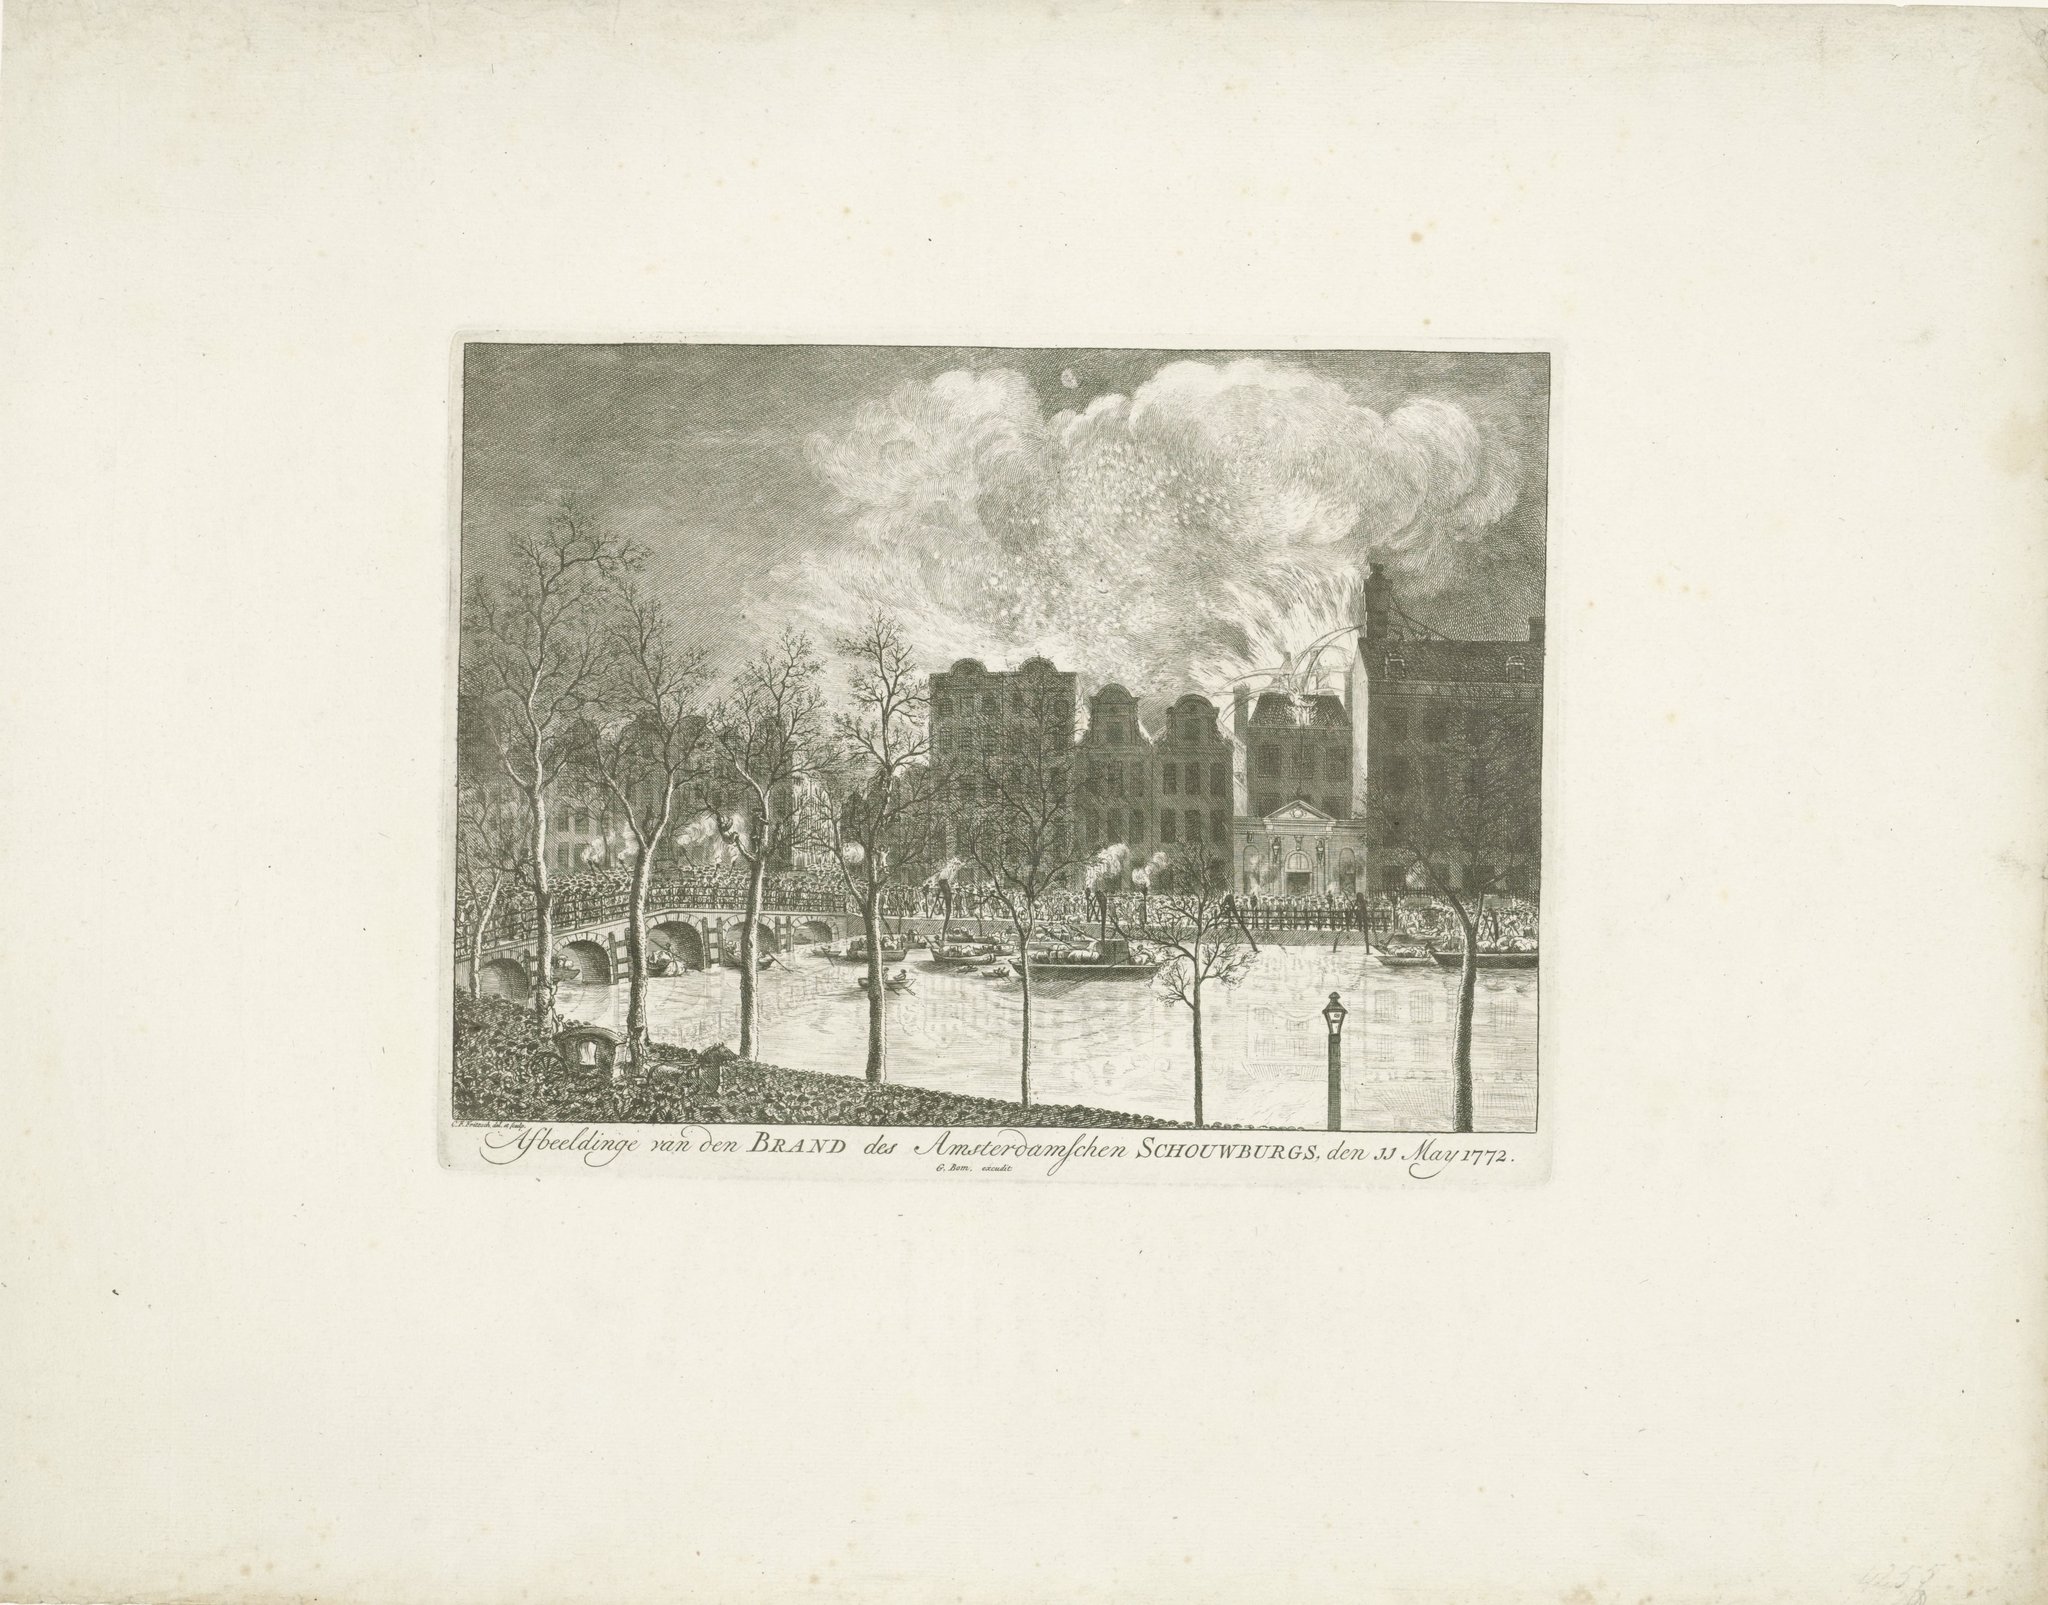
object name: print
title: Afbeelding van den Brand des Amsterdamschen Schouwburgs, den 11 May 1772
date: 1772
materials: paper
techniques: engraving, etching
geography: northern netherlands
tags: on fire, ablaze, theatre, theatrical performance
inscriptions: collector's mark: Lugt 2228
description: De uitslaande brand in de Amsterdamse Schouwburg gezien vanaf de overzijde van de Keizersgracht. De kades en brug staan vol met het toegestroomde publiek.